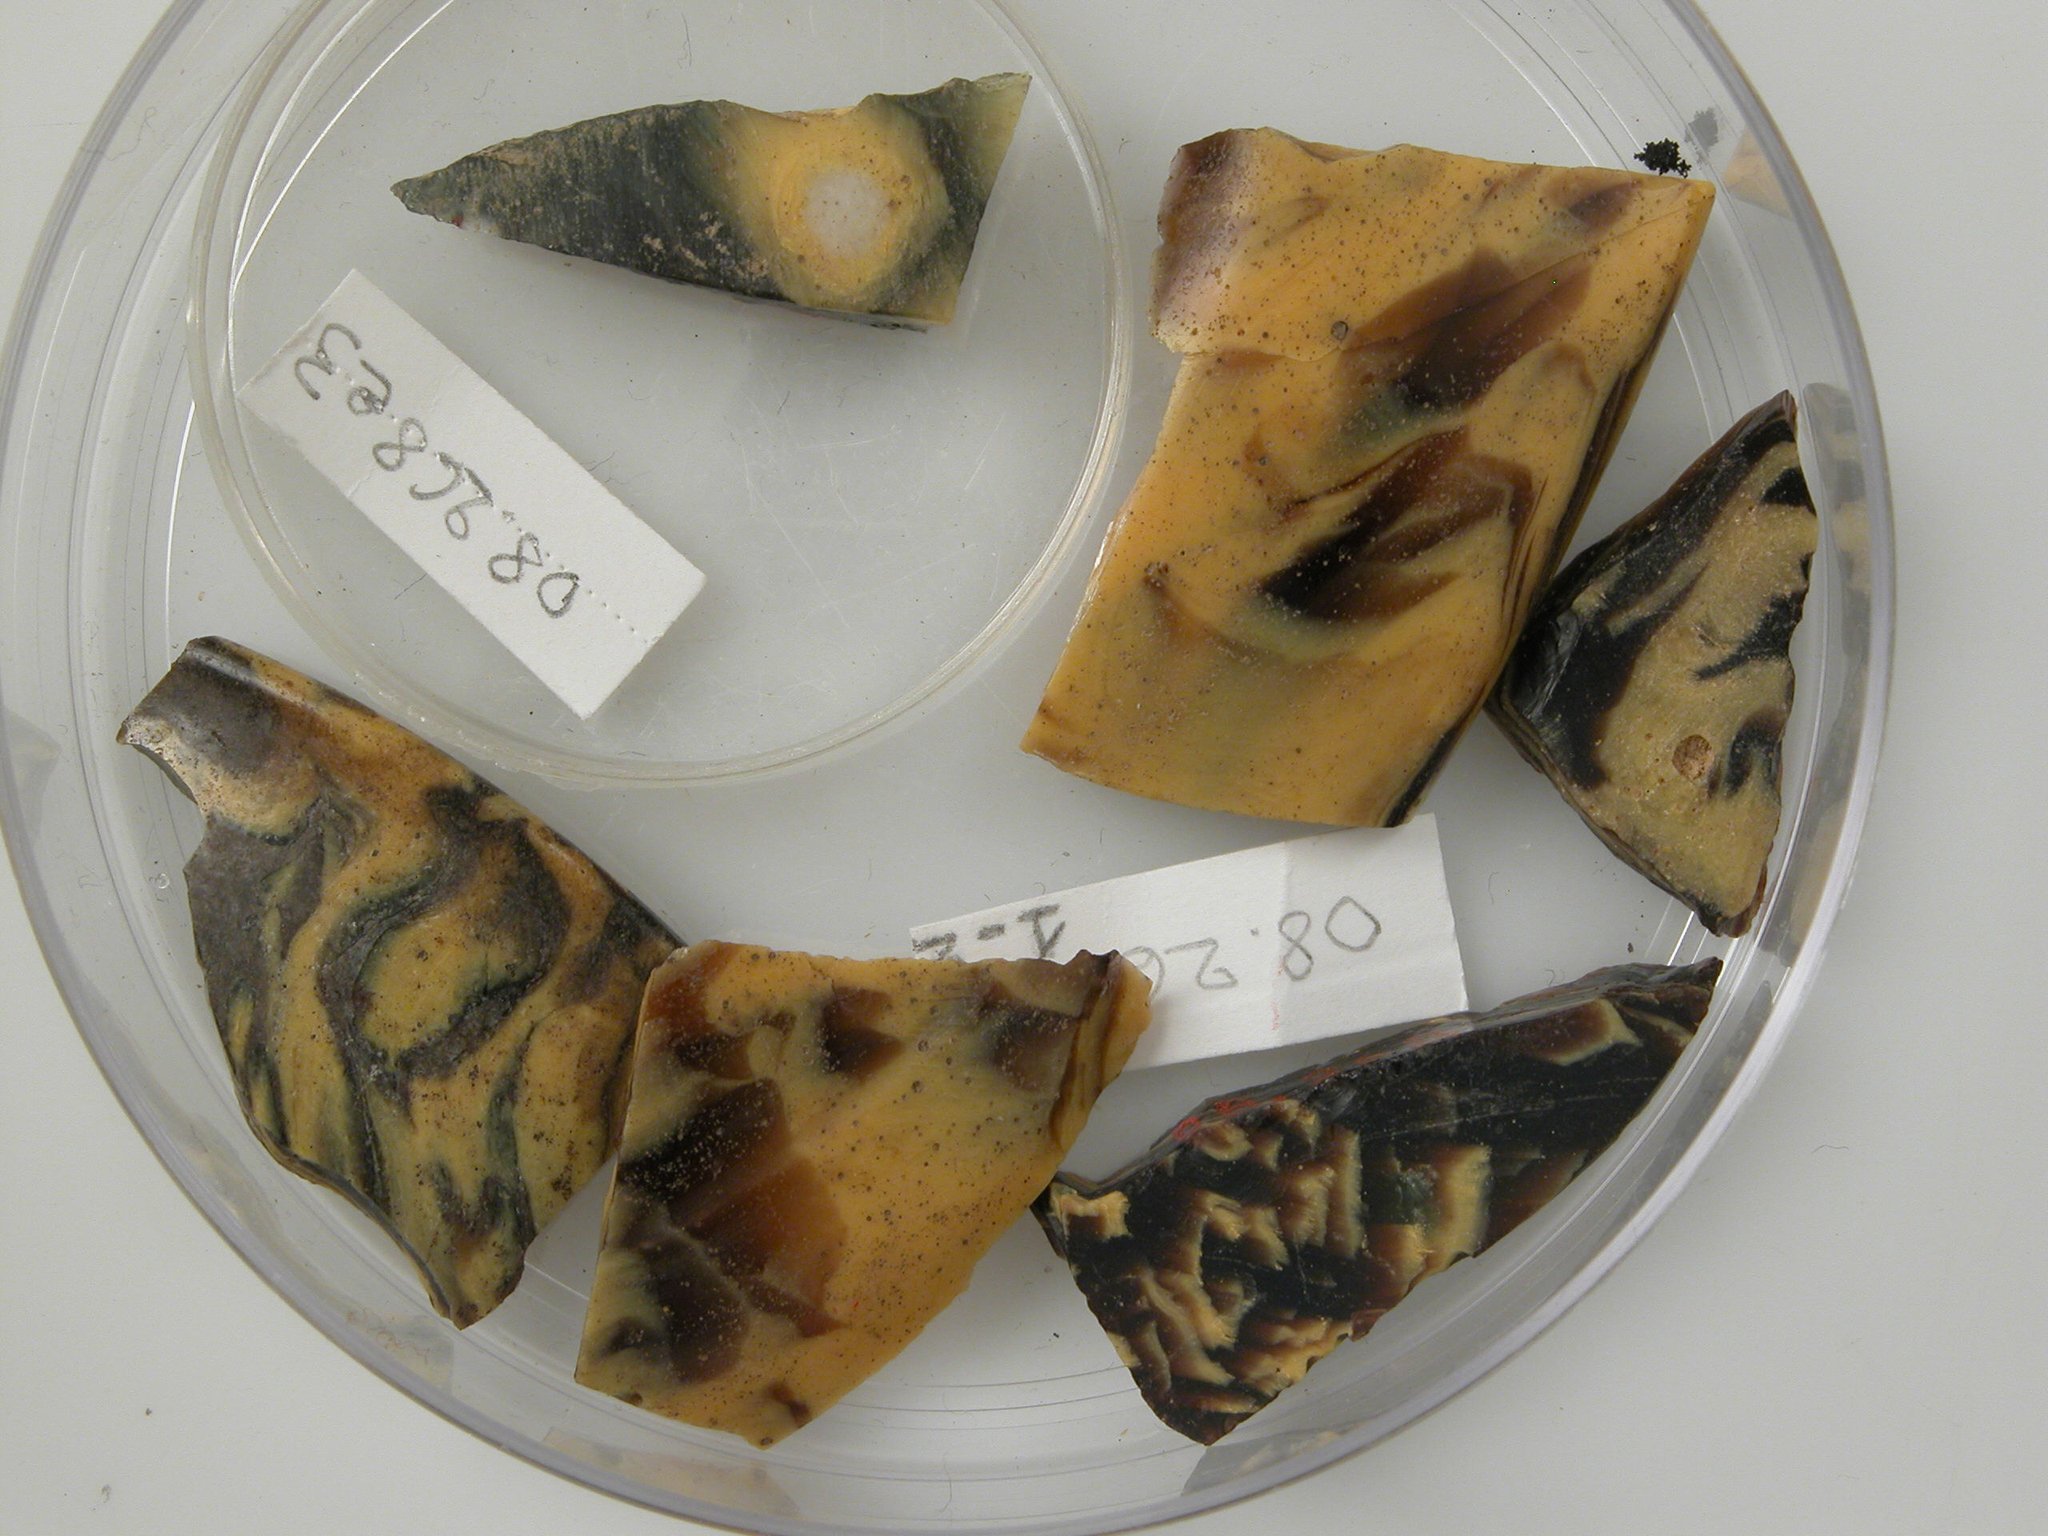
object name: fragment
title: Glass Fragments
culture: coptic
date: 301-433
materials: glass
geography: egypt